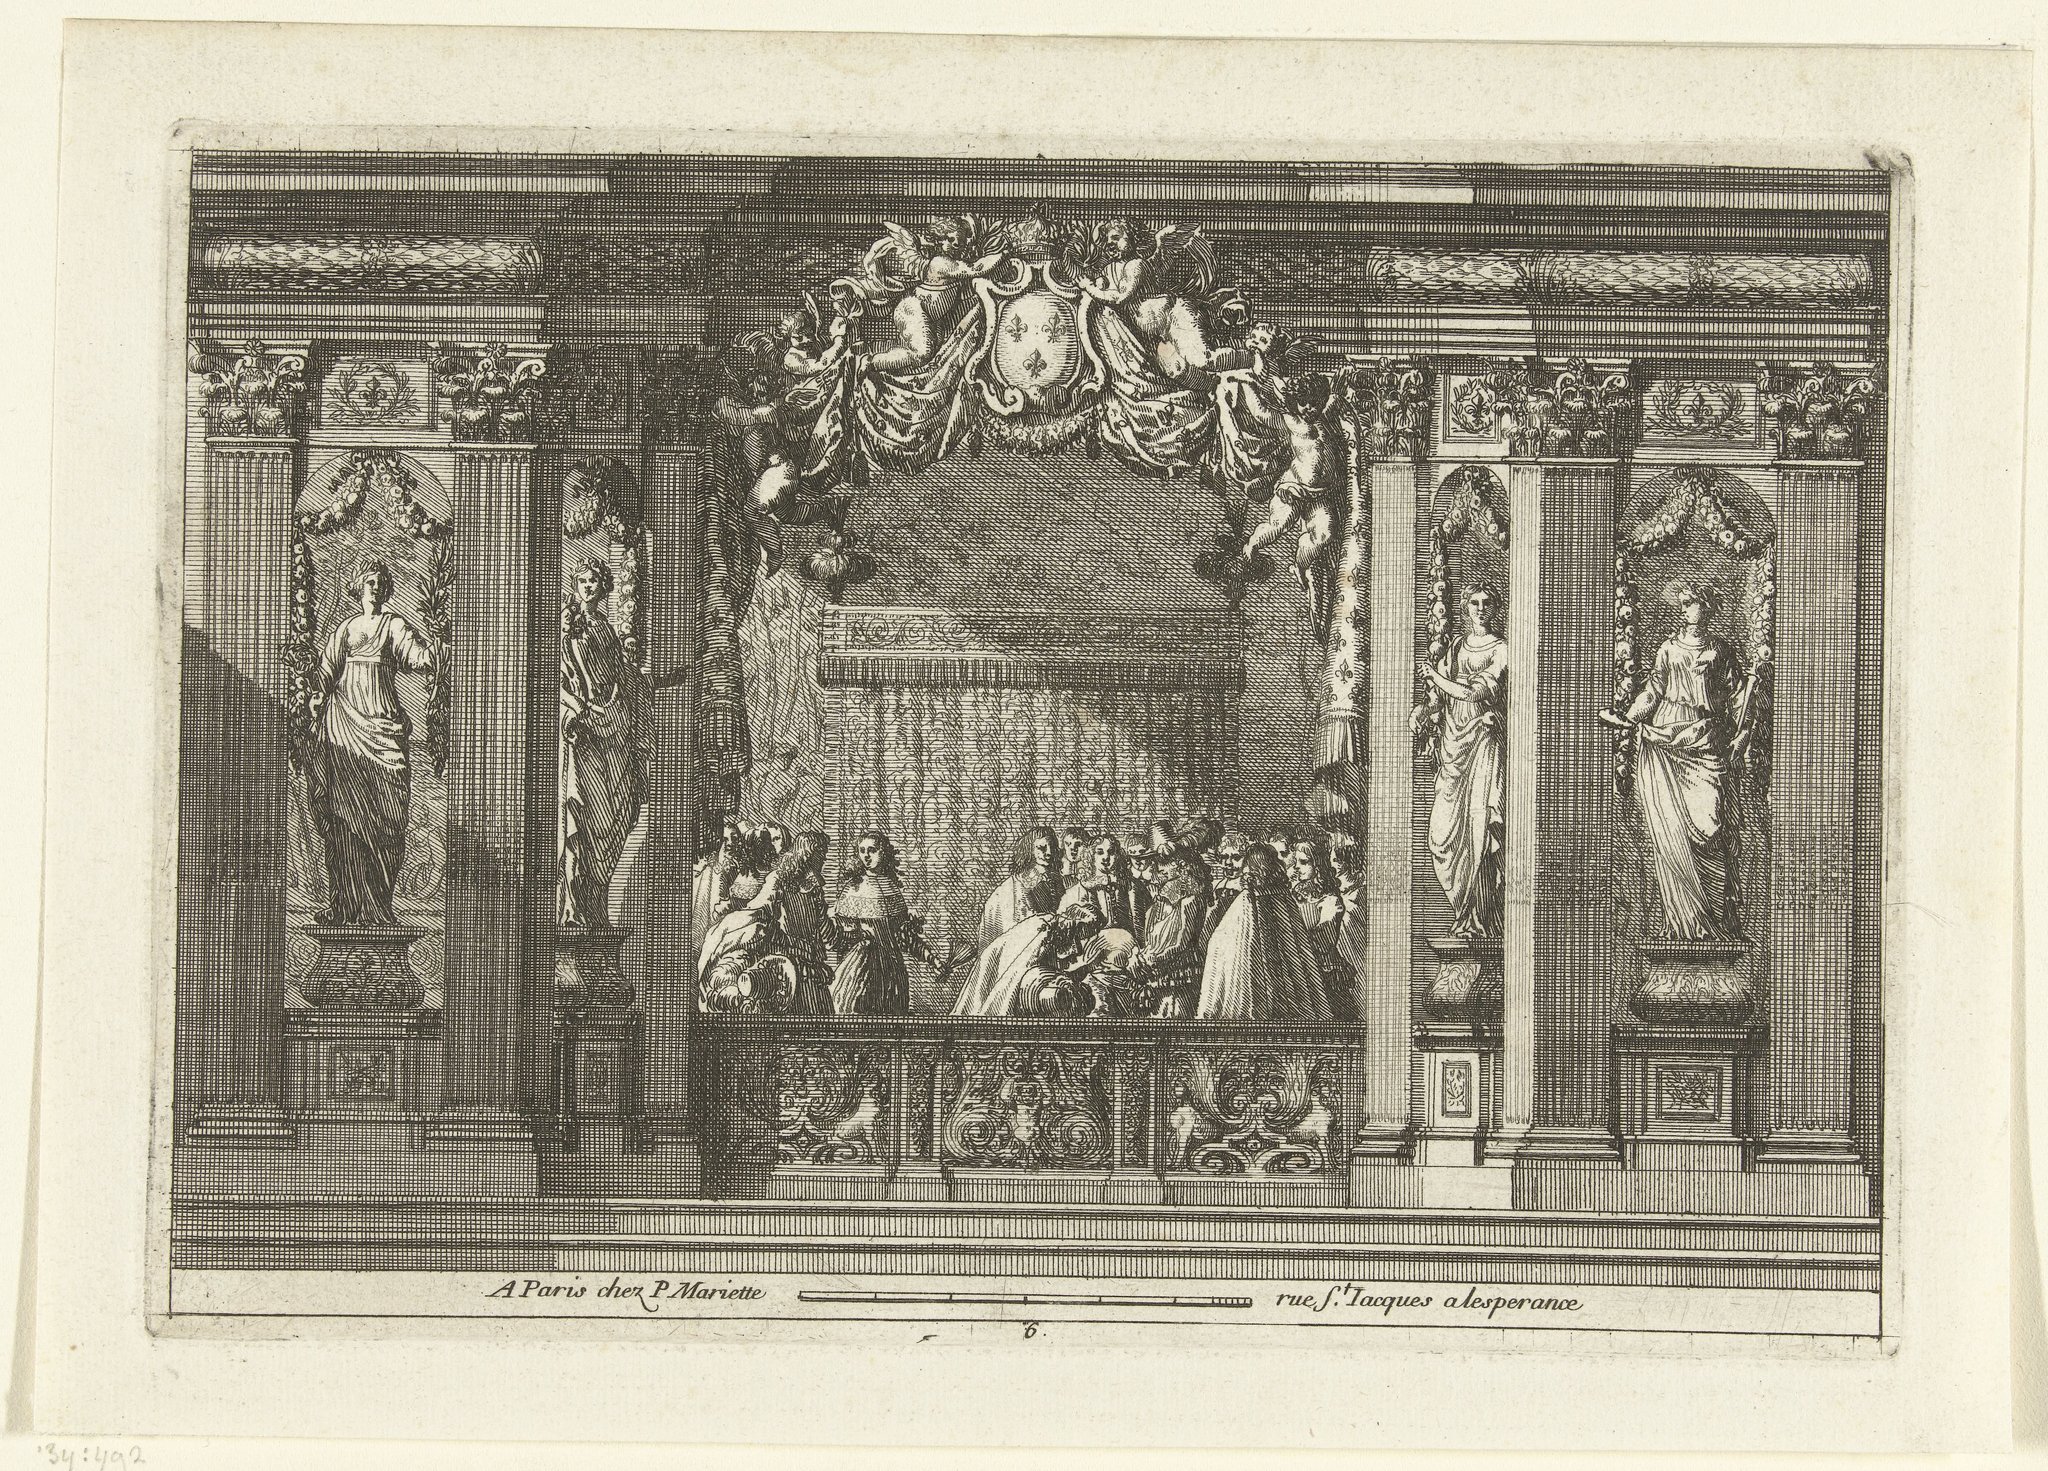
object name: print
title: Alkoof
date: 1656-1657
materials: paper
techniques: etching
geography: france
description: Op de kroonlijst bevindt zich een cartouche met bekroond Frans koninklijk wapenschild. Voor het hemelbed staat de koning omringd door hovelingen. Tweede afdruk uit tweede editie.